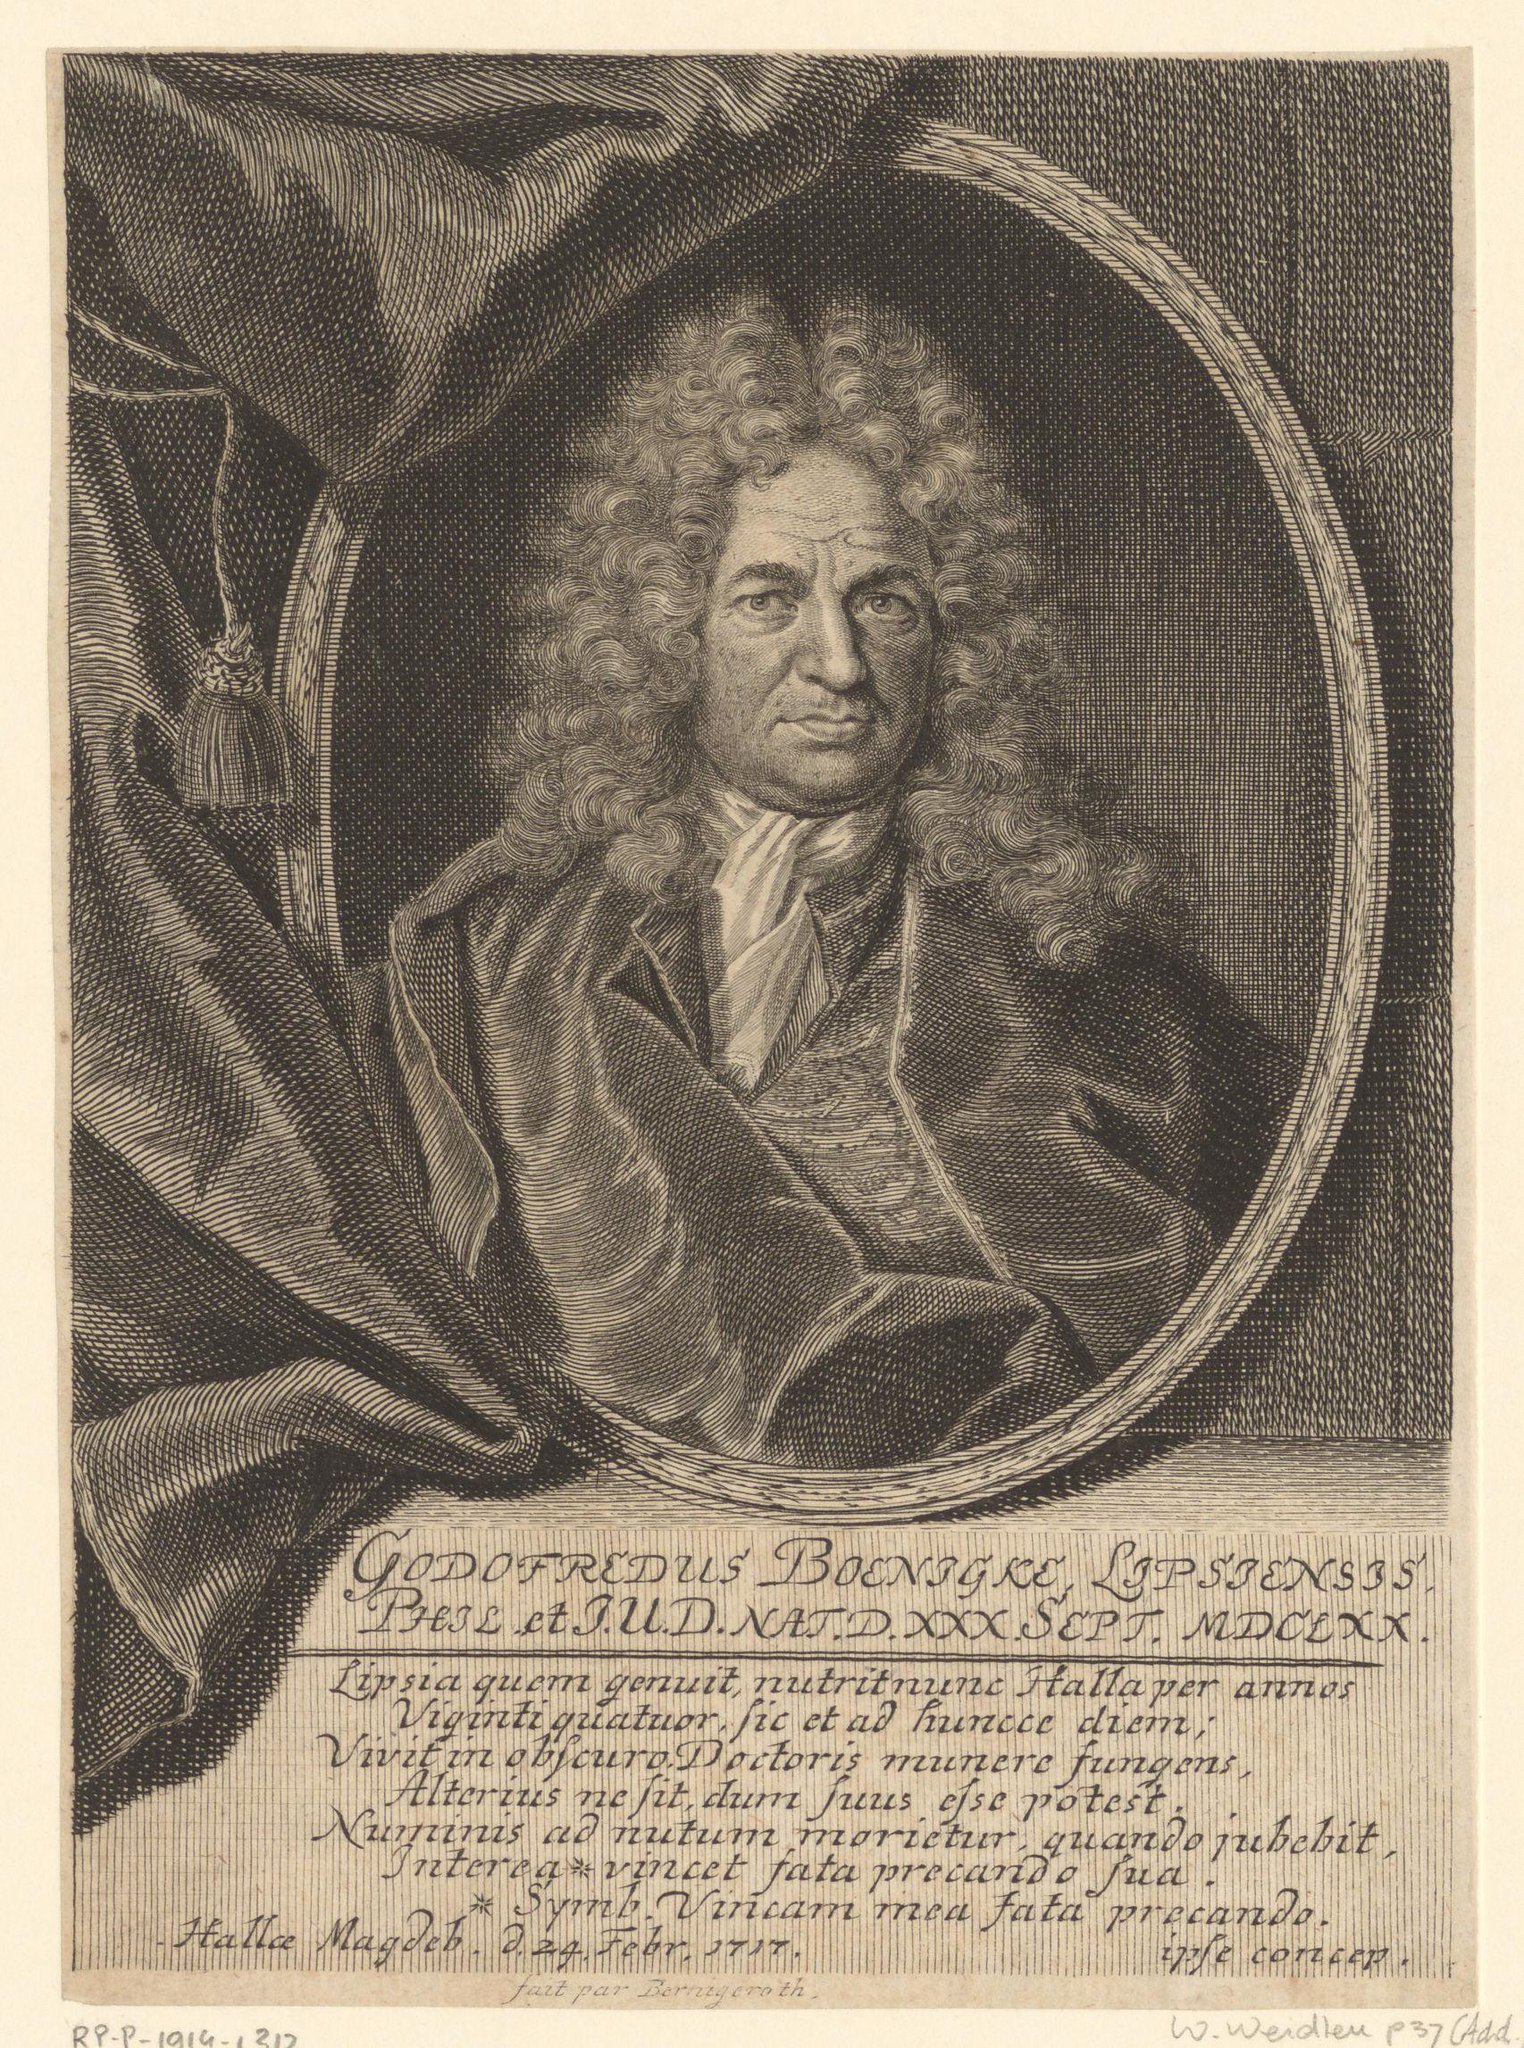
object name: print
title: Portret van Gottfried Bönigke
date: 1717-1733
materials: paper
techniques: engraving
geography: halle an der saale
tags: gottfried bönigke, historical persons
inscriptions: collector's mark: Lugt 2228